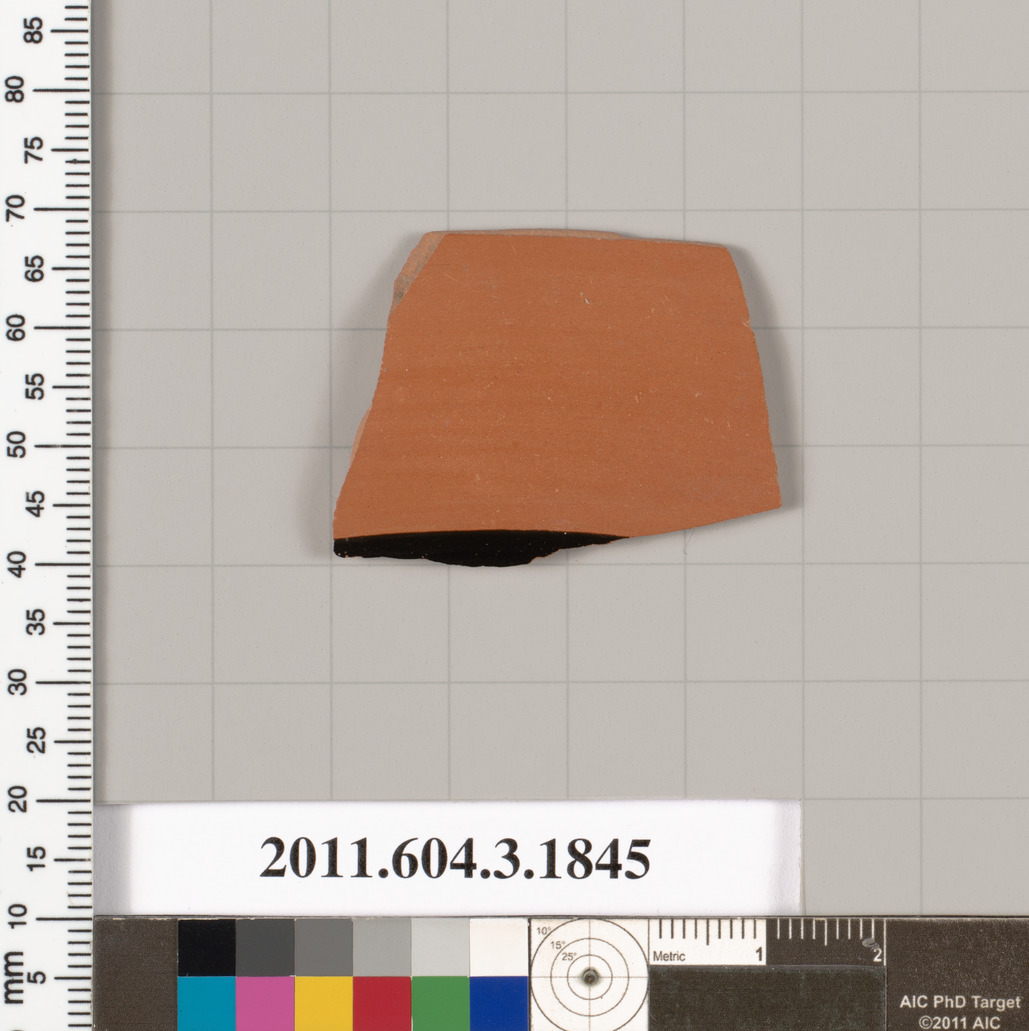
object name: kylix fragment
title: Terracotta fragment of a kylix: Lip cup (drinking cup)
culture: greek, attic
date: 560-525 BCE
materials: terracotta